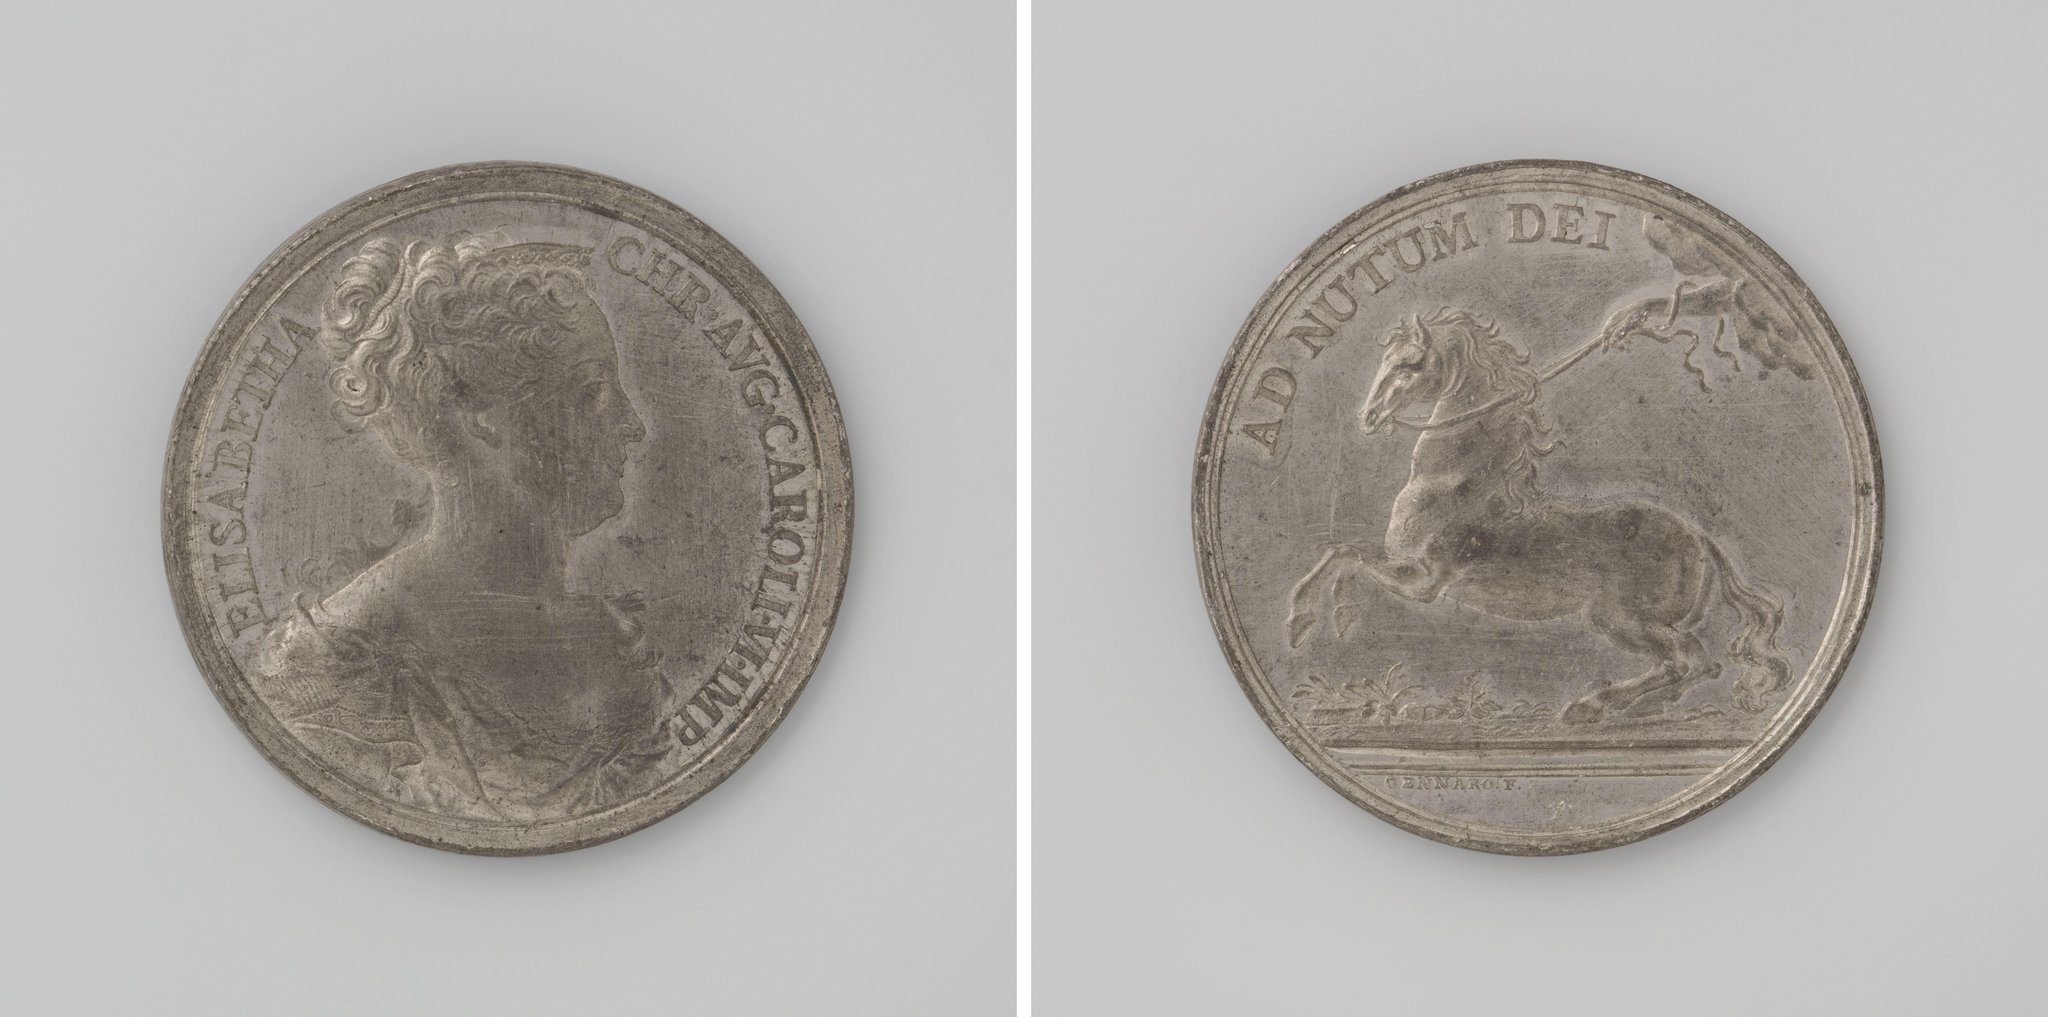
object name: history medal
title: Elisabeth Christine van Brunswijk-Wolfenbüttel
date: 1723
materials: tin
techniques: striking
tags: keizerin, elisabeth christina (keizerin van oostenrijk)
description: Tinnen penning. Voorzijde: borststuk vrouw binnen omschrift. Keerzijde: galopperend Lüneburgs paard wordt door hand uit wolken gemend binnen omschrift.